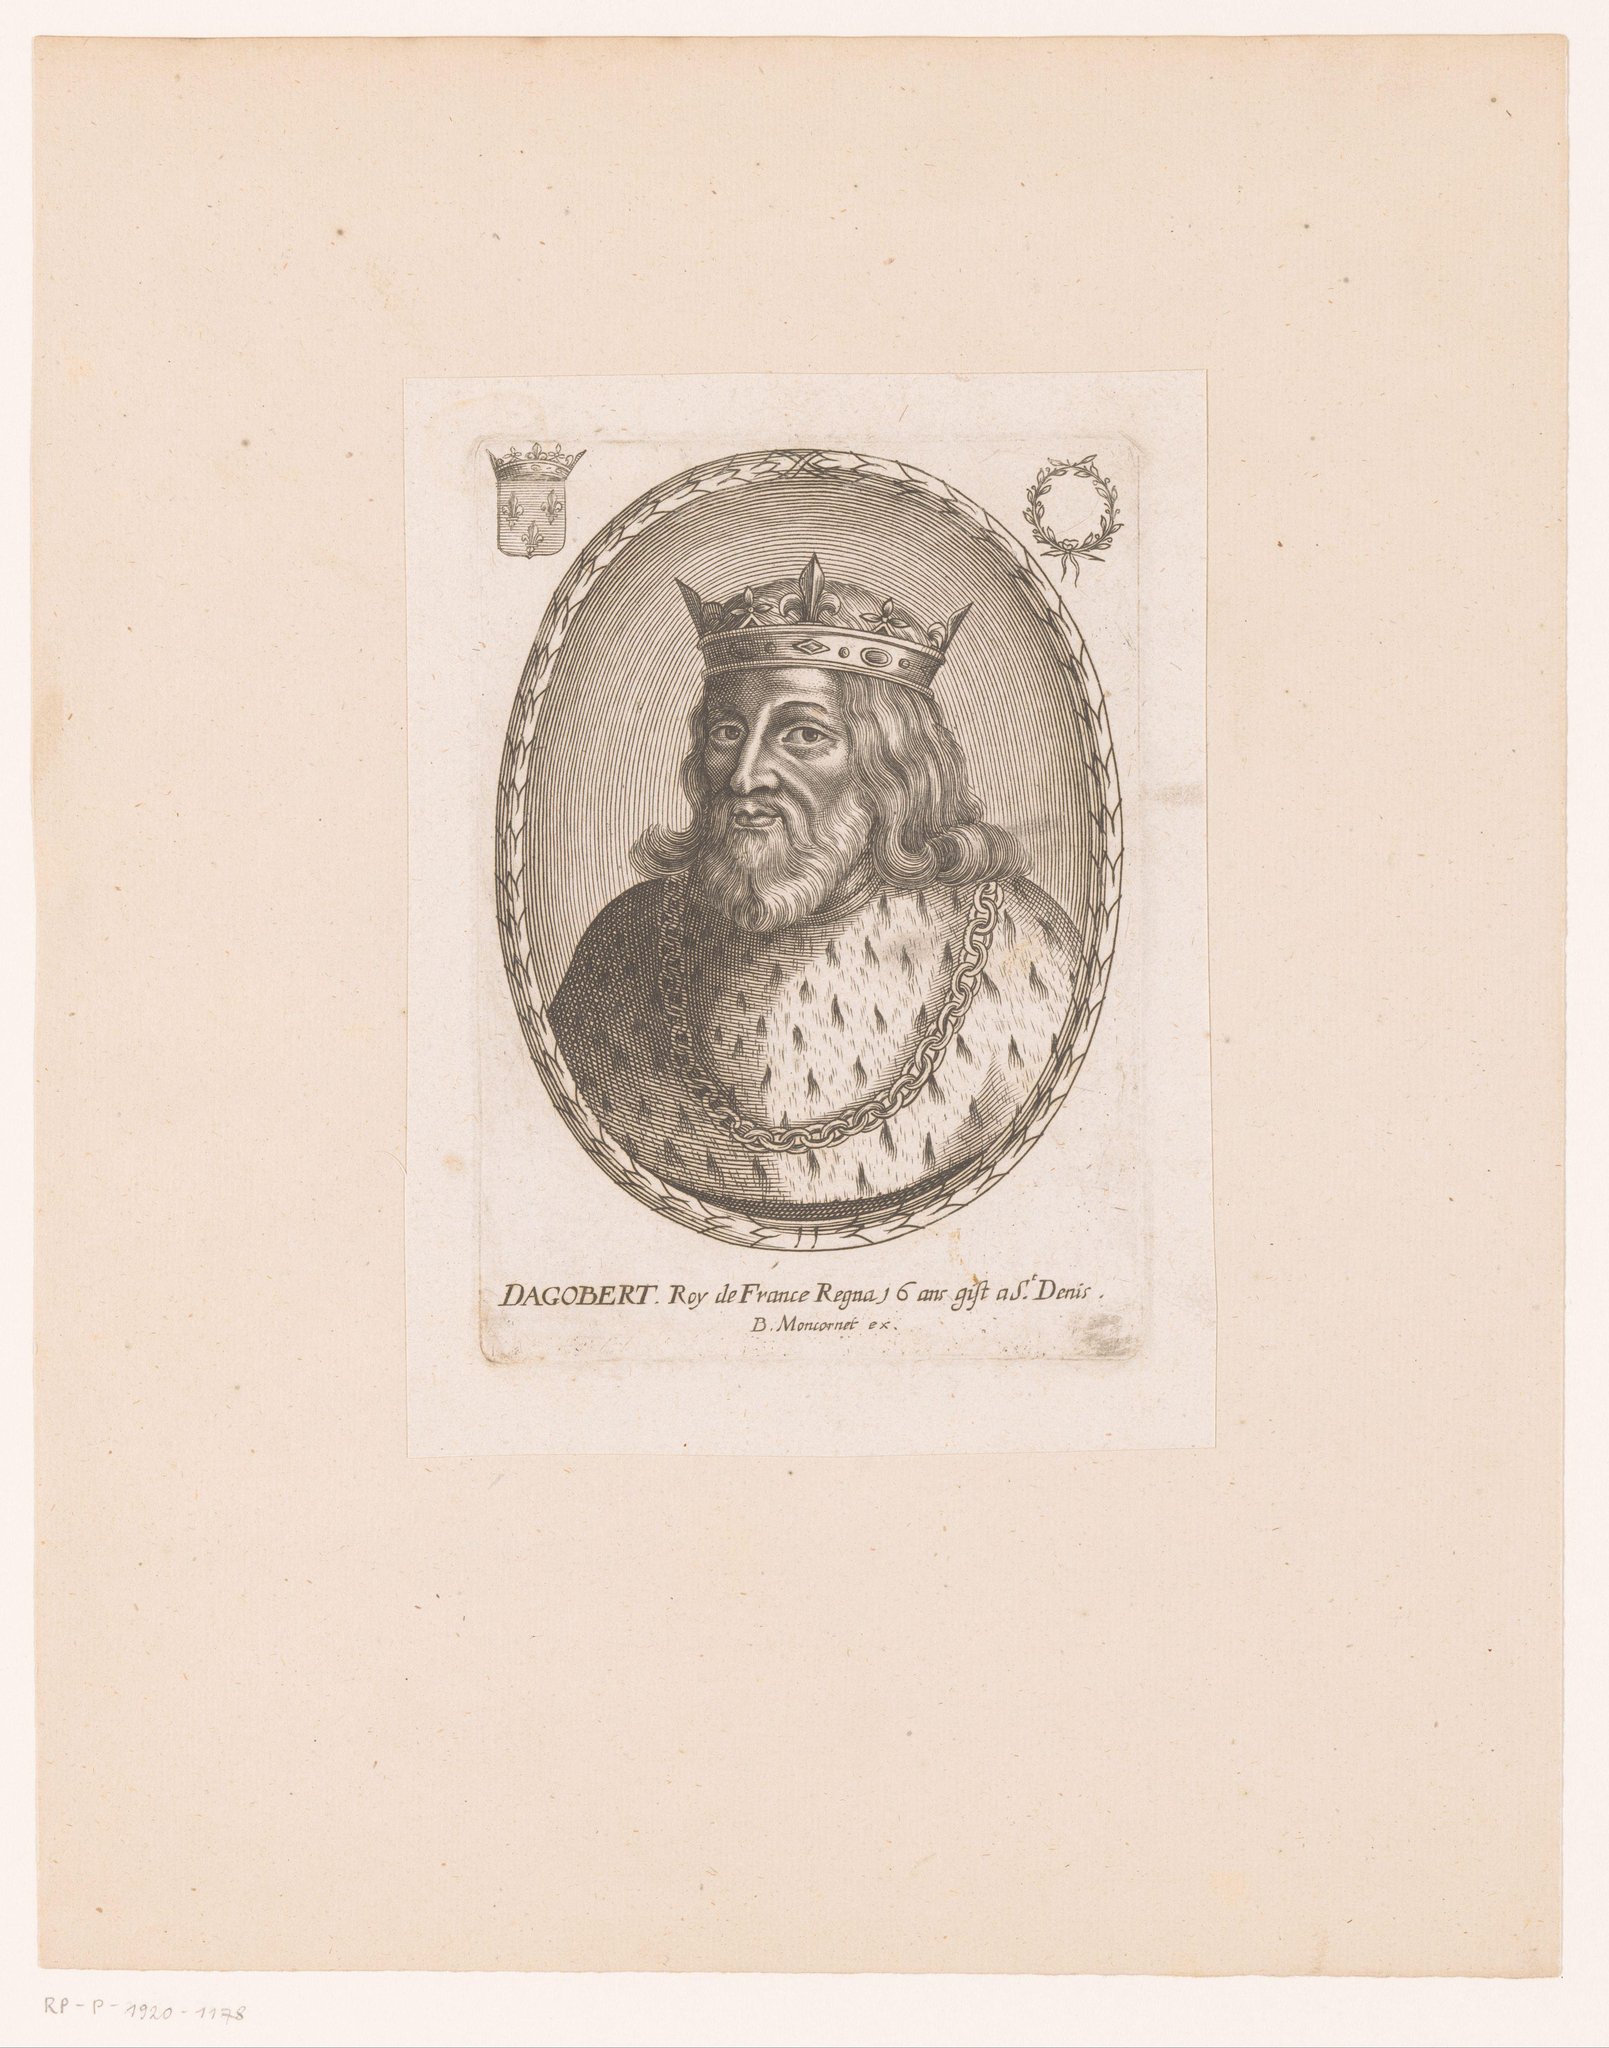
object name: print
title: Portret van Dagobert I, koning van Frankrijk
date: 1610-1668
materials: paper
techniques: engraving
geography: paris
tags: historical persons, king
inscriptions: collector's mark: Lugt 2228